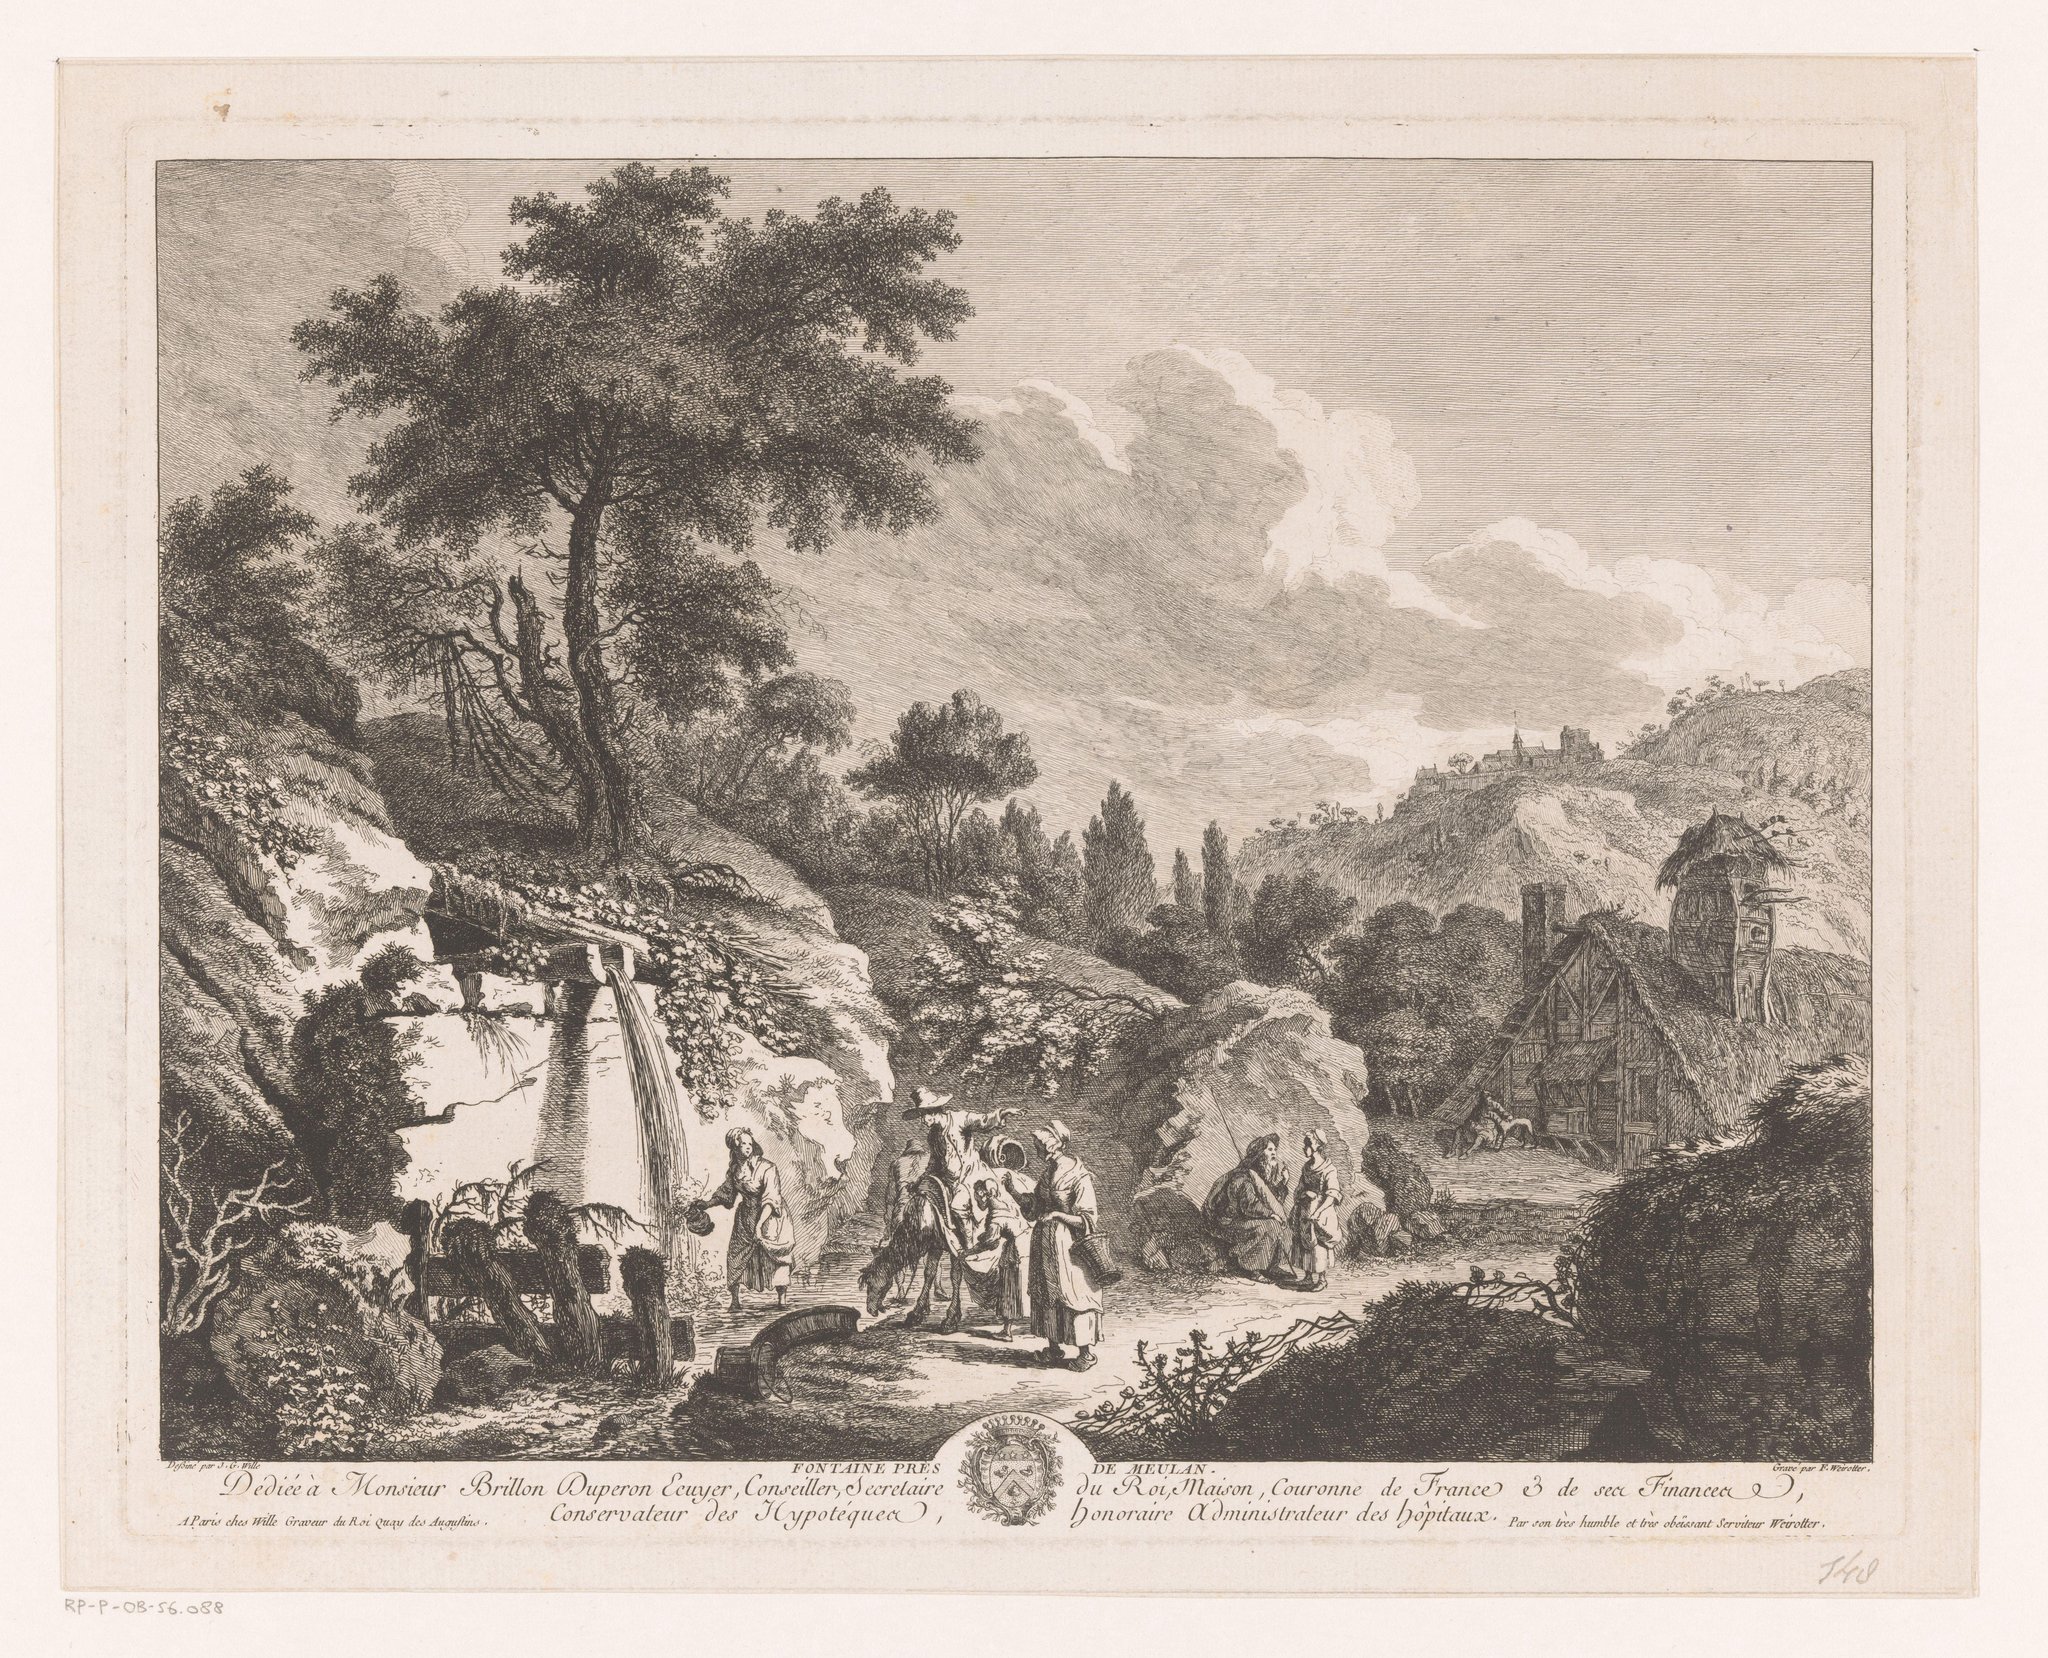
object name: print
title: Fontaine près de Meulan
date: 1760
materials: paper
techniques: etching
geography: paris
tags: riding a horse, ass, or mule; rider, horseman, city-view, and landscape with man-made constructions, (high) hill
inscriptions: collector's mark: Lugt 240